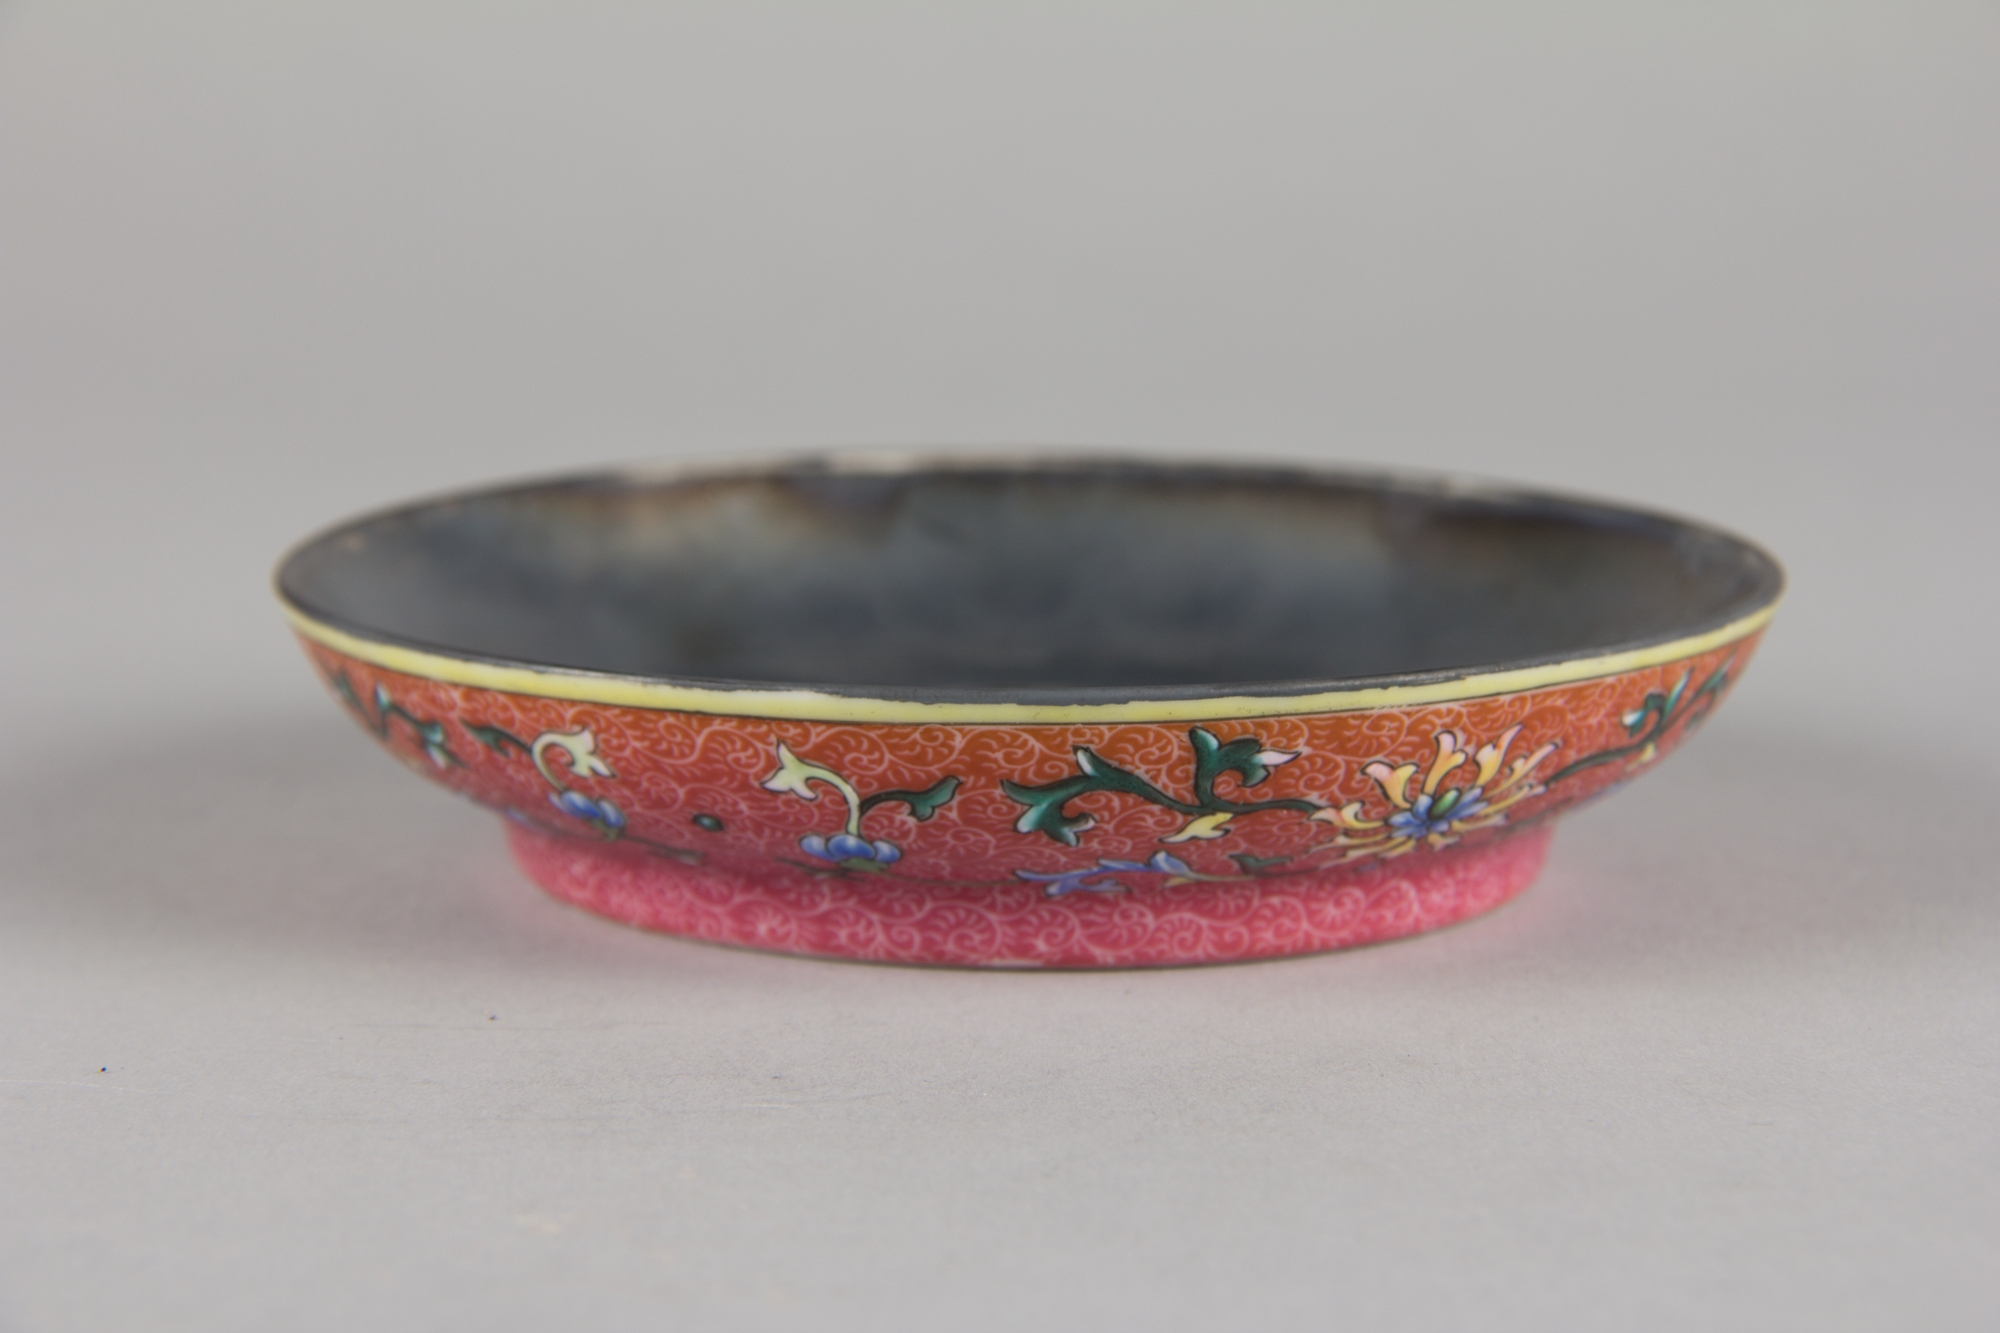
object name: saucer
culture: chinese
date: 1801-1850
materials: enamel, porcelain, silver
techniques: engraving, overglaze, painting, polychrome